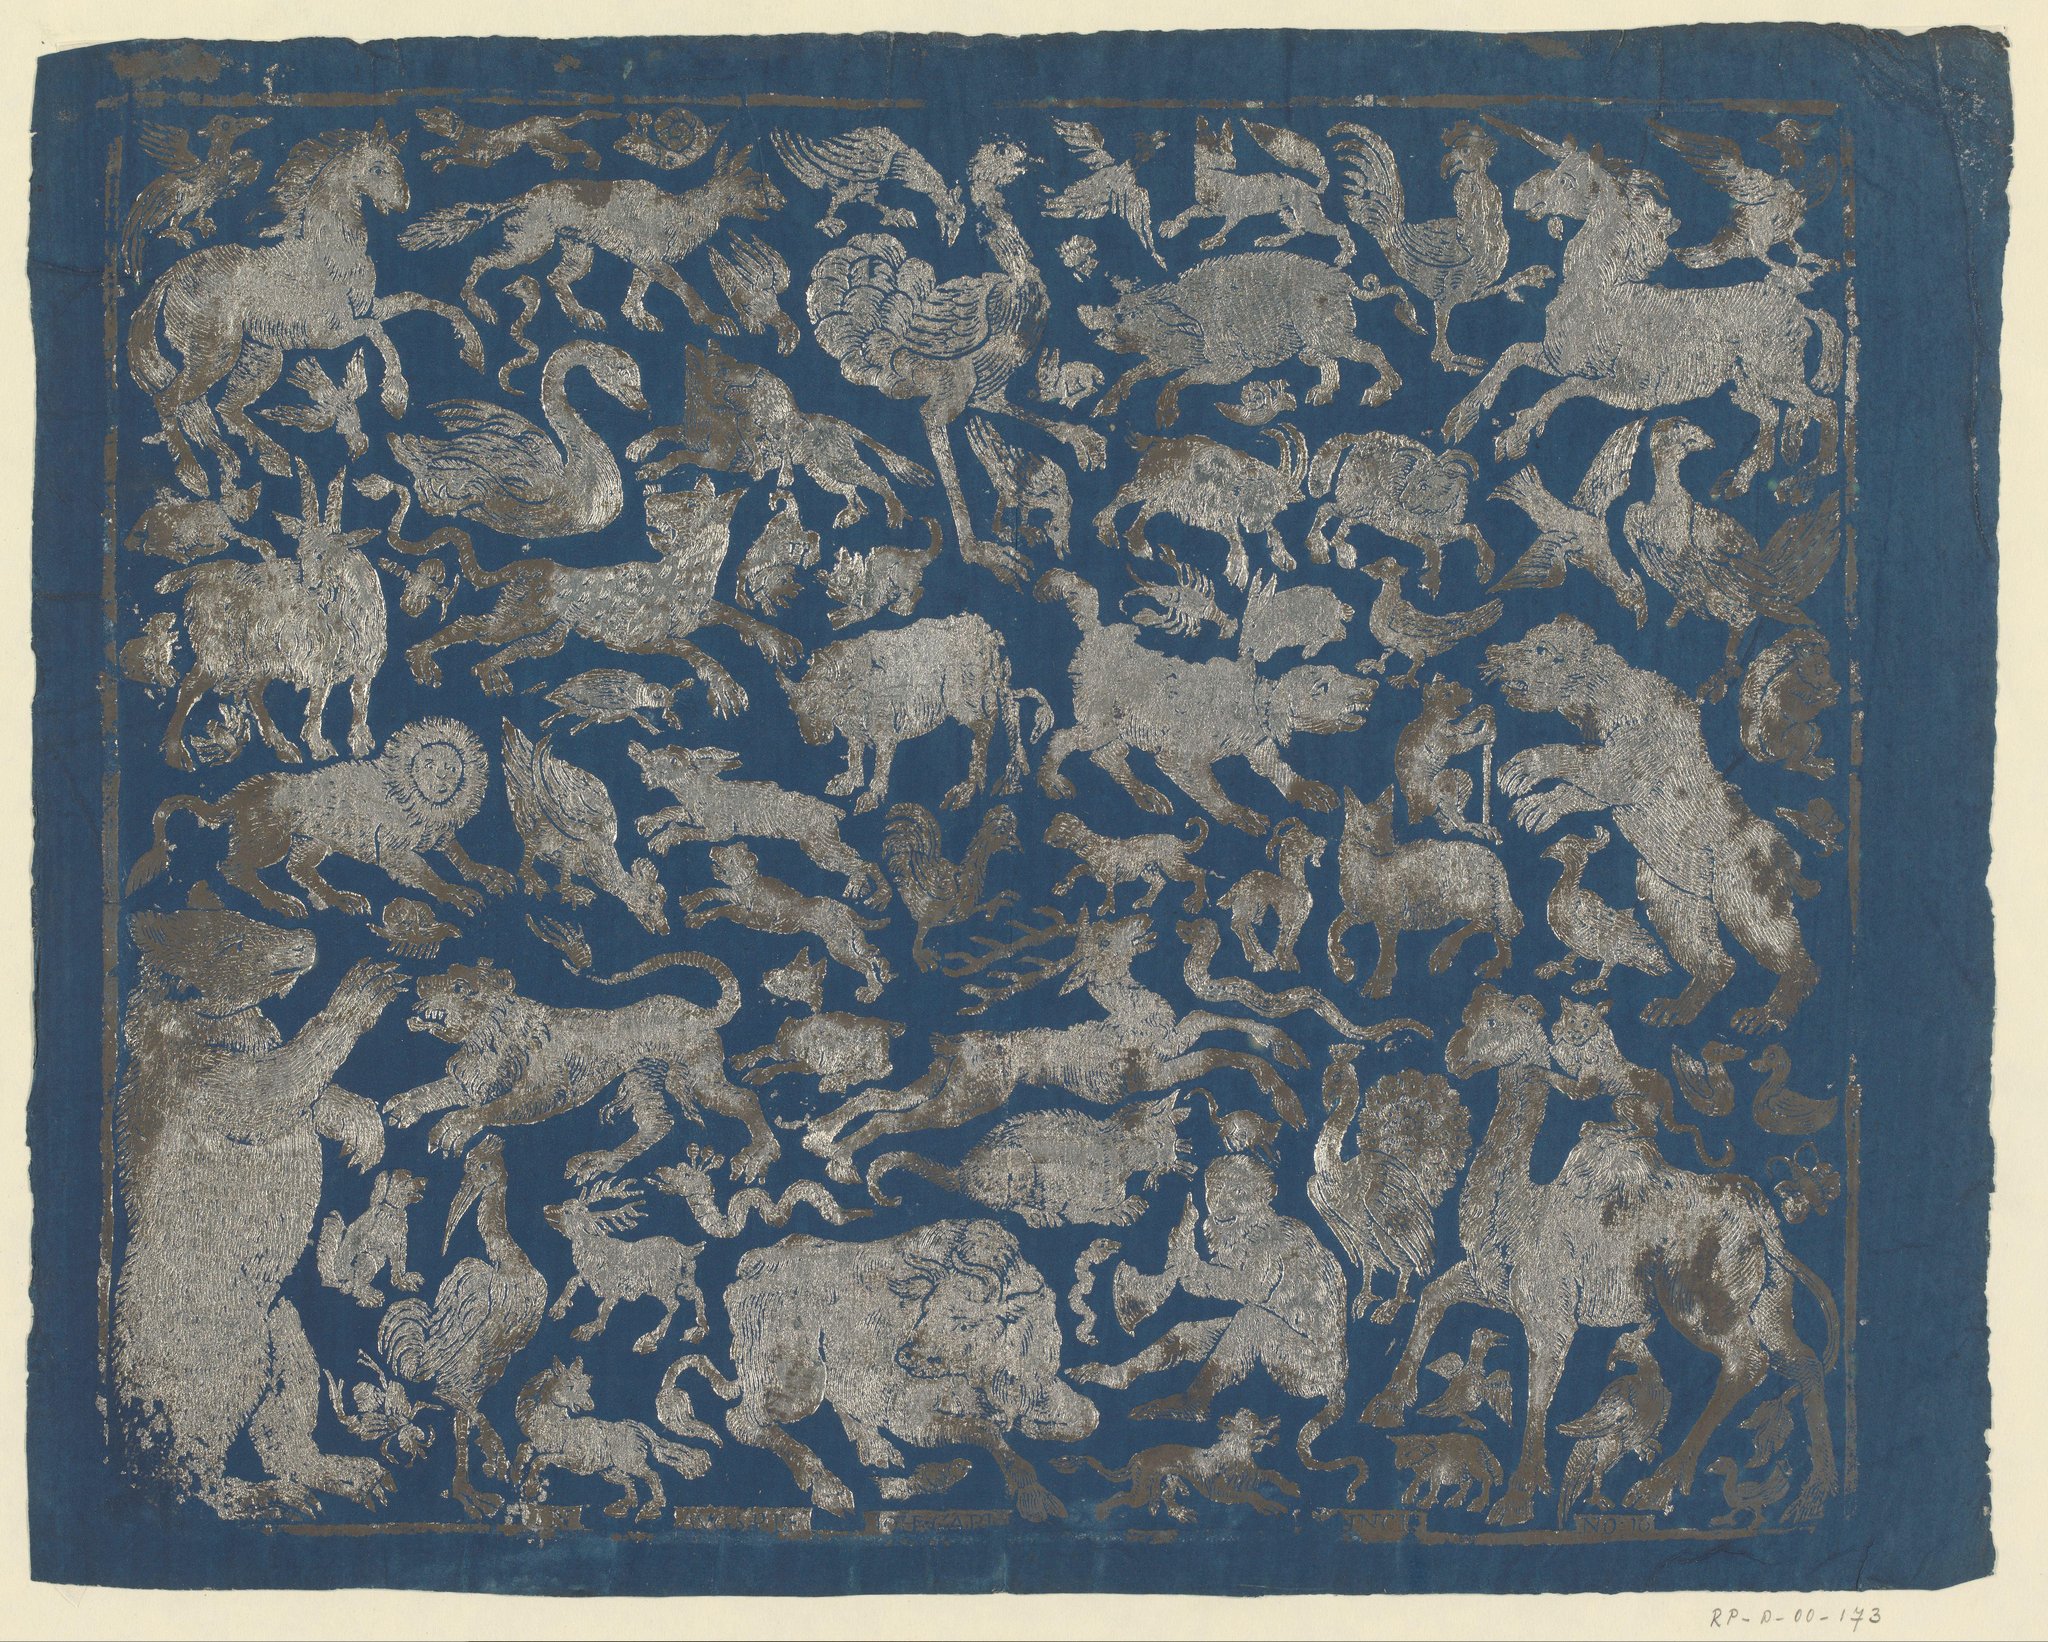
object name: brocade paper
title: Blad met dieren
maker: johann carl munck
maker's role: ontwerper sierpapier, papiermaker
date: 1750-1794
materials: paper, silver leaf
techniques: relief print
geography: augsburg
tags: unicorn, animals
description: Blad met dieren; linksboven paard, rechtsboven eenhoorn, linksonder beer, rechtsonder dromedaris. Onderaan genummerd: 16.